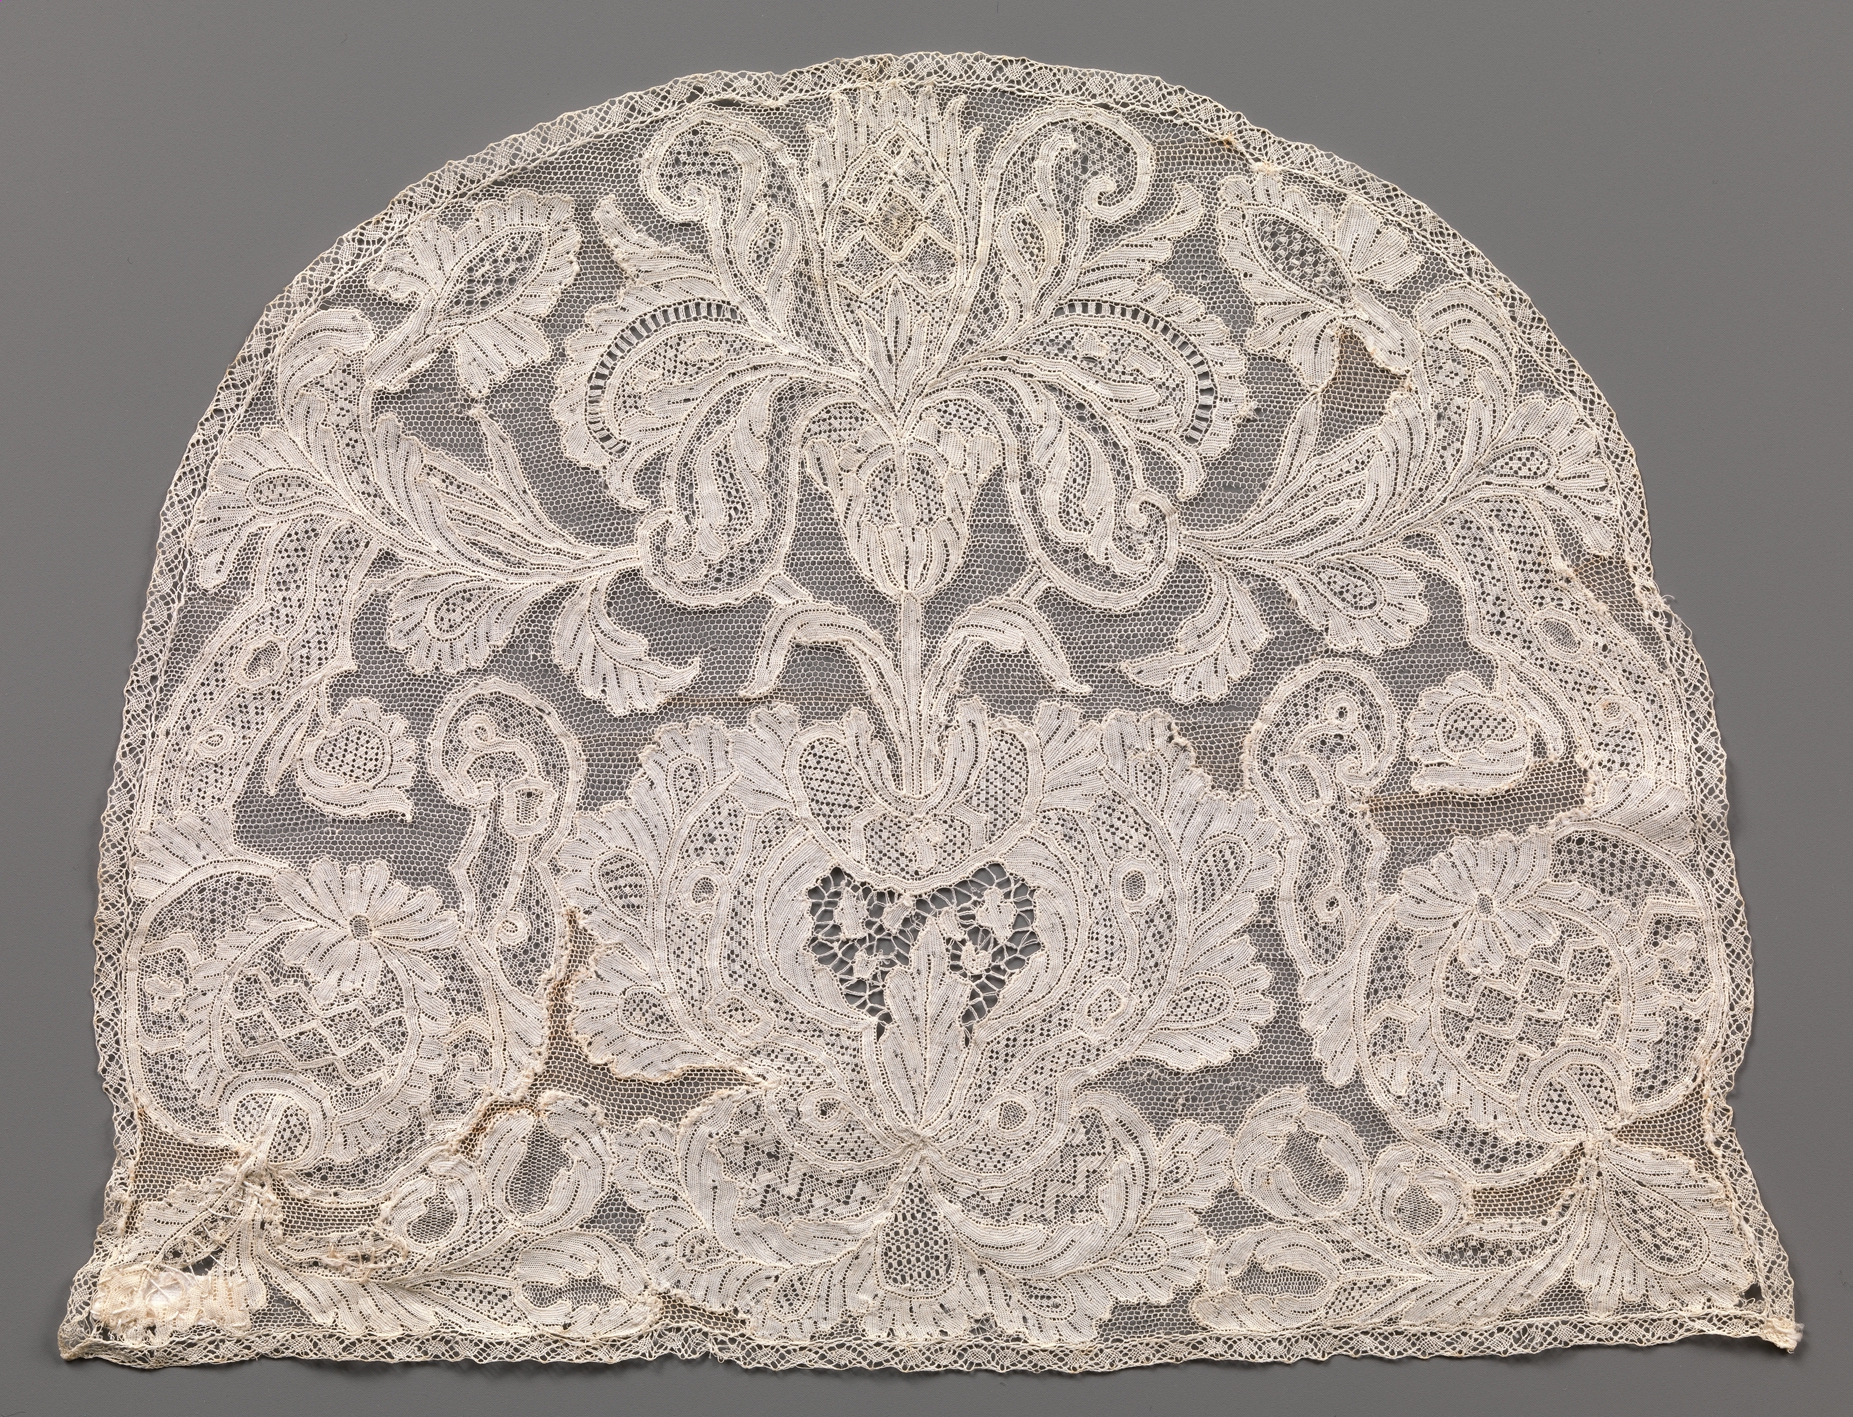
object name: cap crown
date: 1701-1750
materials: linen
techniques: lace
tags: flowers